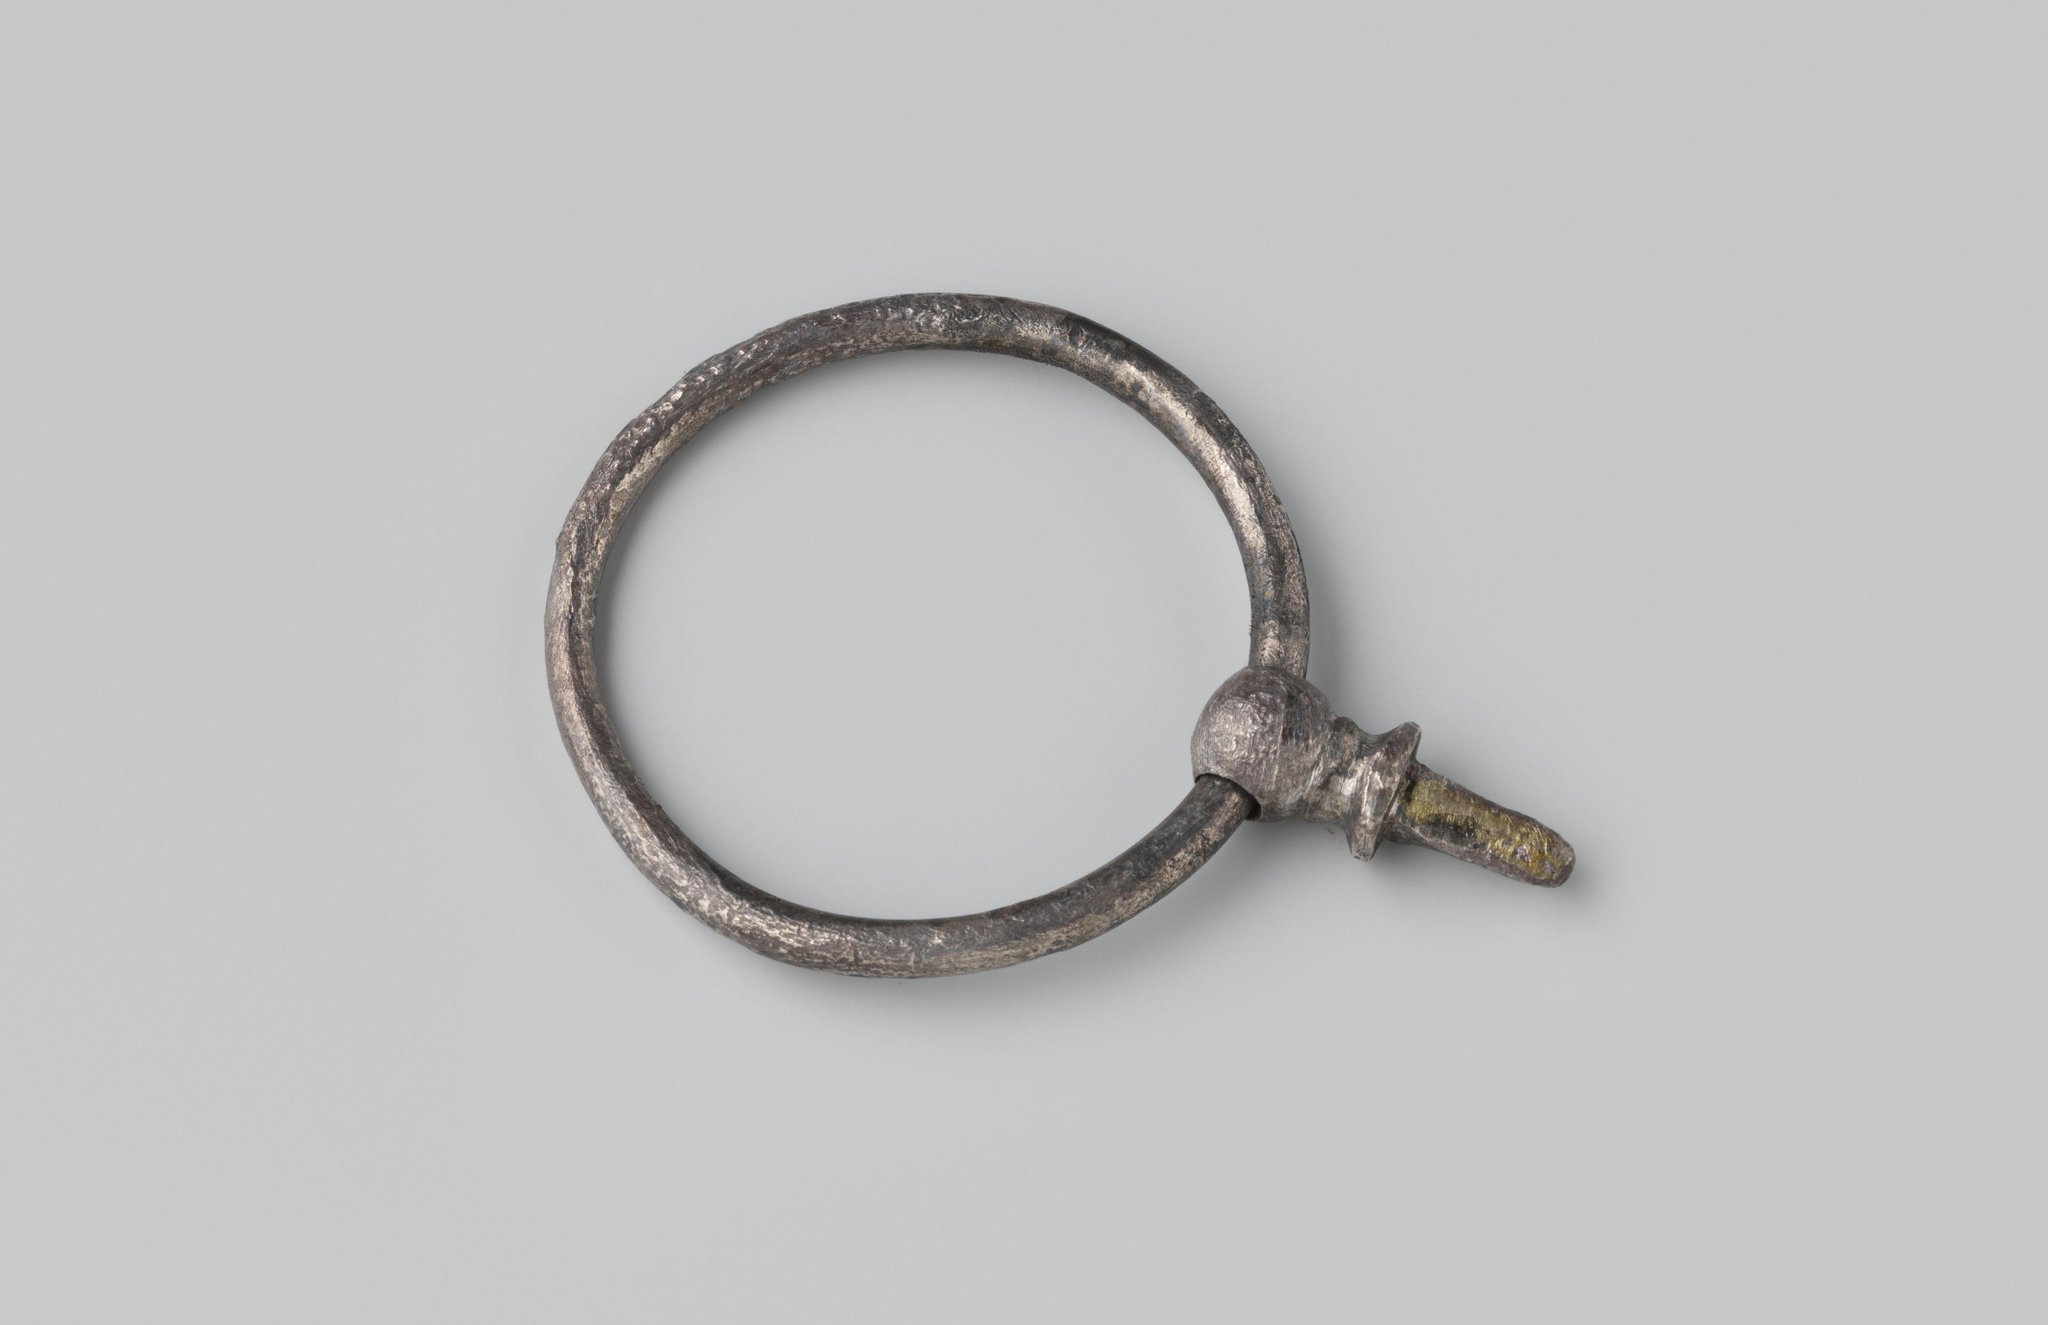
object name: handle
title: Ringhandvat uit het wrak van de Oost-Indiëvaarder Hollandia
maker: Anonymous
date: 1700-1743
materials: silver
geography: netherlands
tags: verenigde oostindische compagnie, hollandia (schip), annet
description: Fittings, handles, loop handle; circular ring, circular in section, hinged, running through a spherical knop on a square tapering tenon.